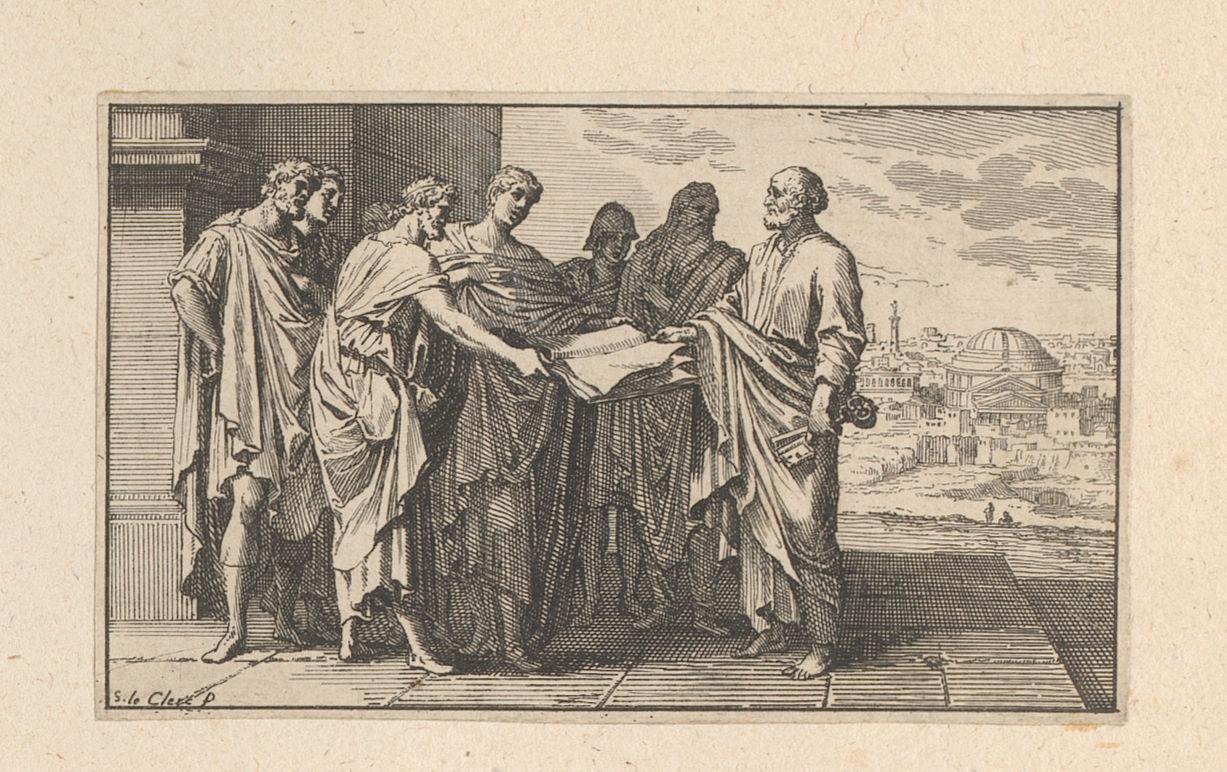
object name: book illustration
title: Vignet met de H. Petrus bij andere figuren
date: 1685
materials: paper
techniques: etching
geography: paris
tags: the apostle peter, first bishop of rome; possible attributes: book, cock, (upturned) cross, (triple) crozier, fish, key, scroll, ship, tiara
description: Prent uit: Maimbourg, Le P. Louis. Traité historique de l'établissement (...). Parijs: Sébastien Mabre-Cramoisy, 1685.